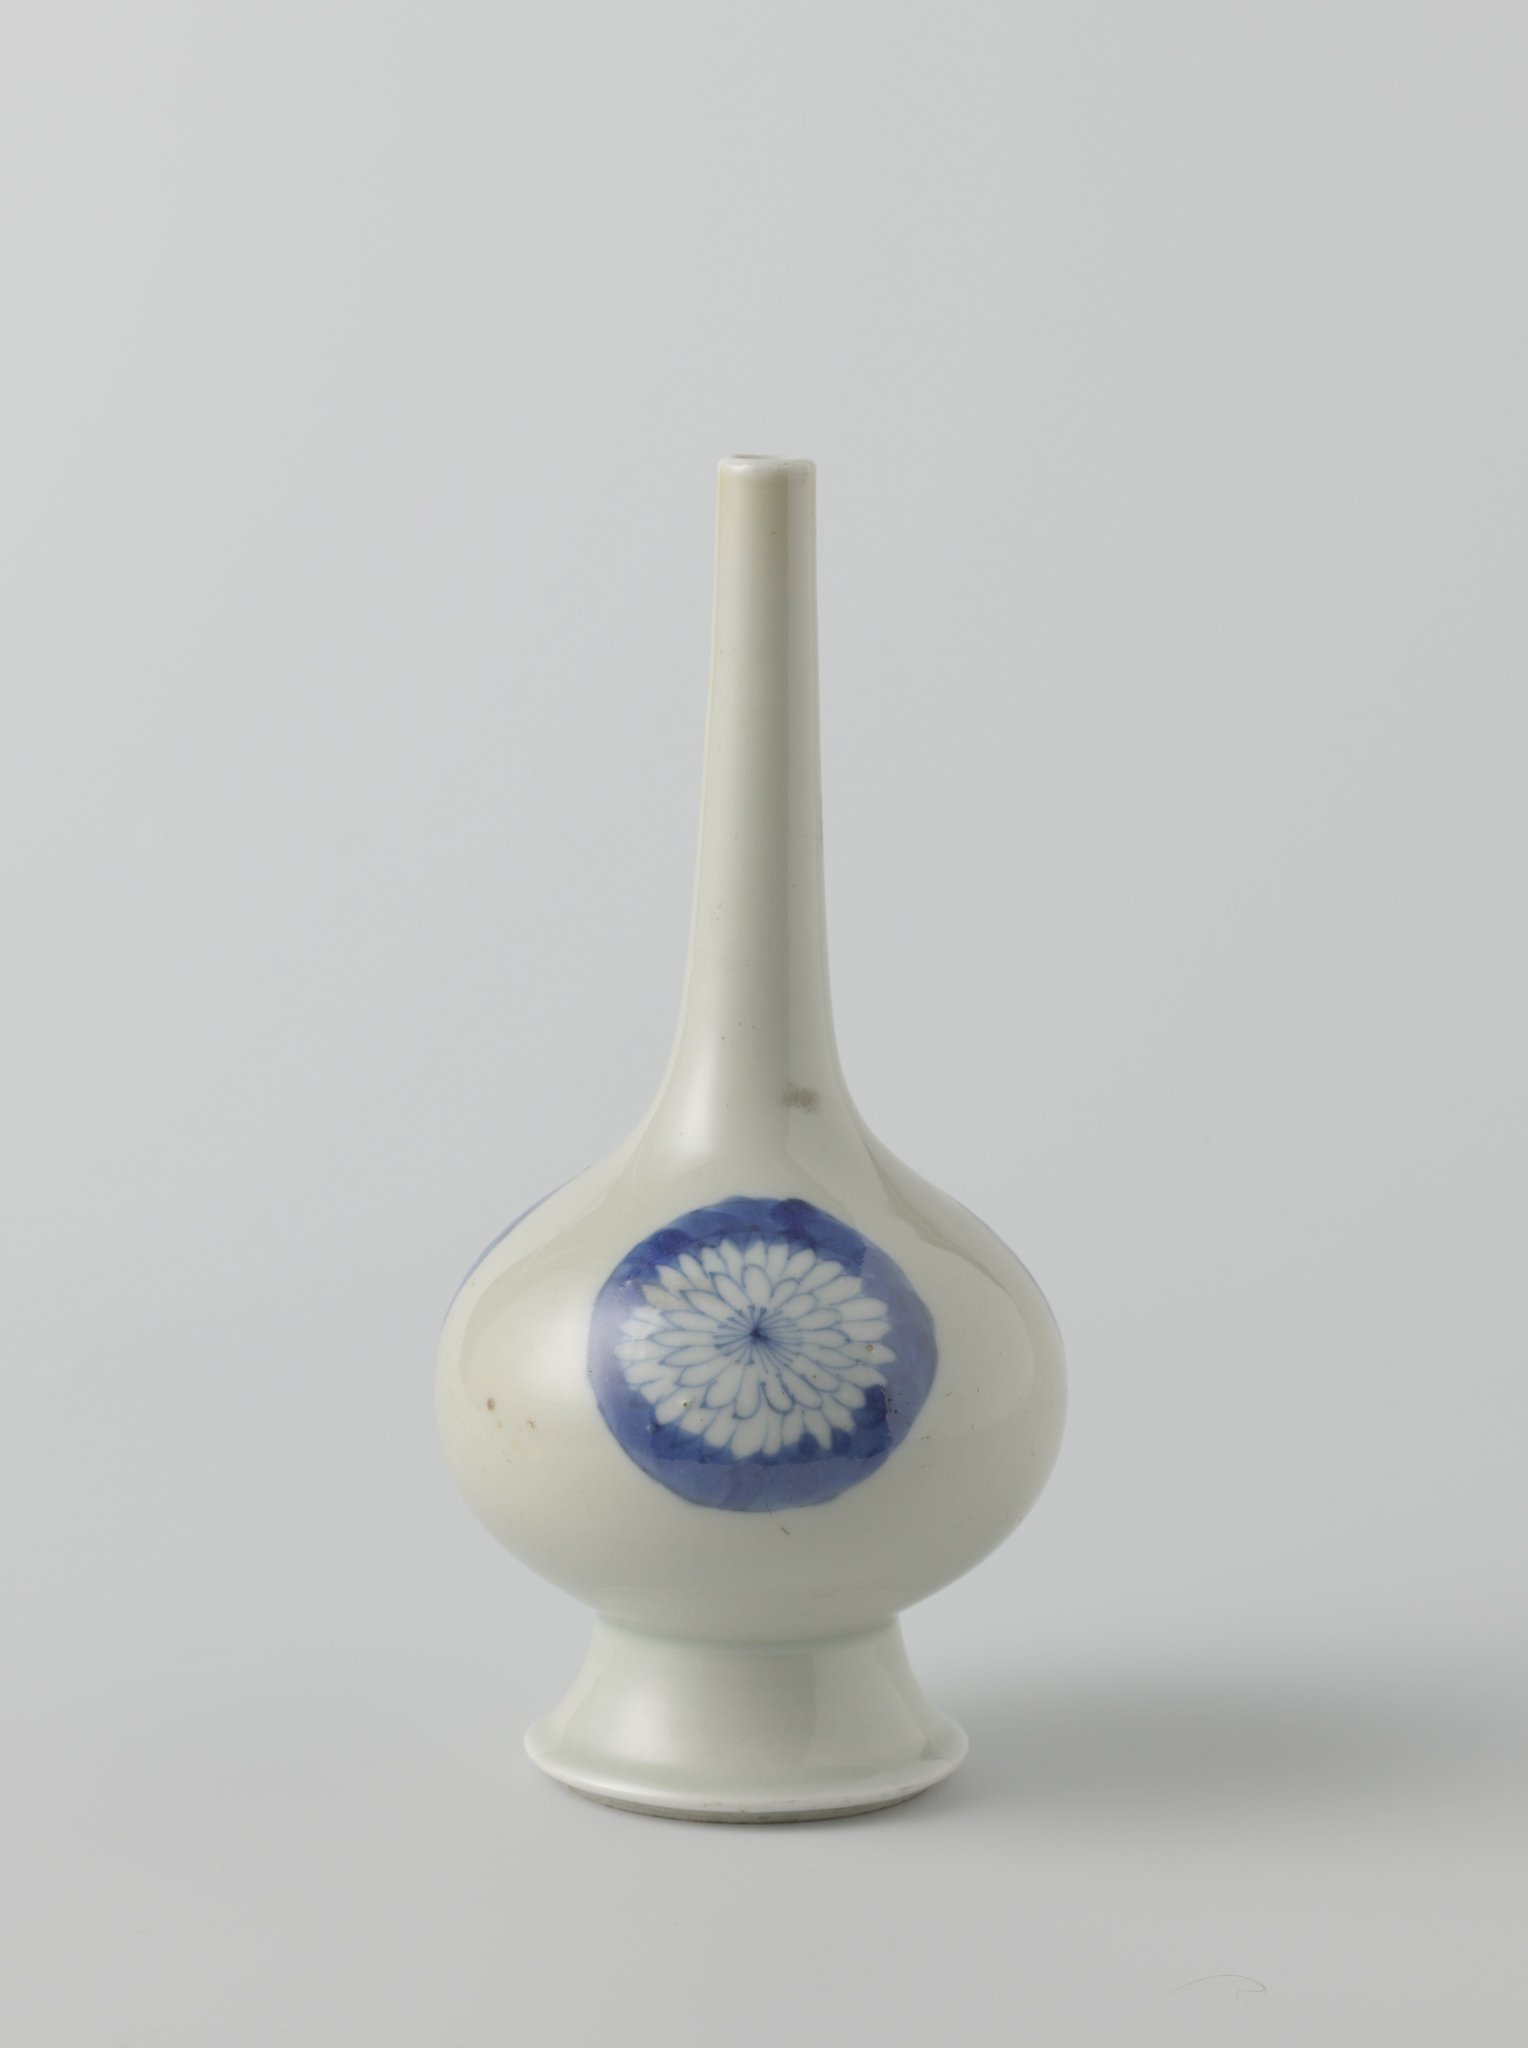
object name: sprinkler flask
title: Rosewater sprinkler or bottle with celadon green and chrysanthemums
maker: Anonymous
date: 1700-1724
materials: cobalt, glaze, paint, porcelain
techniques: firing, turning, vitrification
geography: china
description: Rozenwater druppelaar of puntfles op hoge voet van porselein met bolvormig lichaam en lange, smalle nek, bedekt met een celadongroen glazuur en beschilderd in onderglazuur blauw. De fles is bedekt met een celadon groen glazuur en in onderglazuur blauw drie ronde reserves met chrysant. Monochroom celadon groen met onderglazuur blauw.